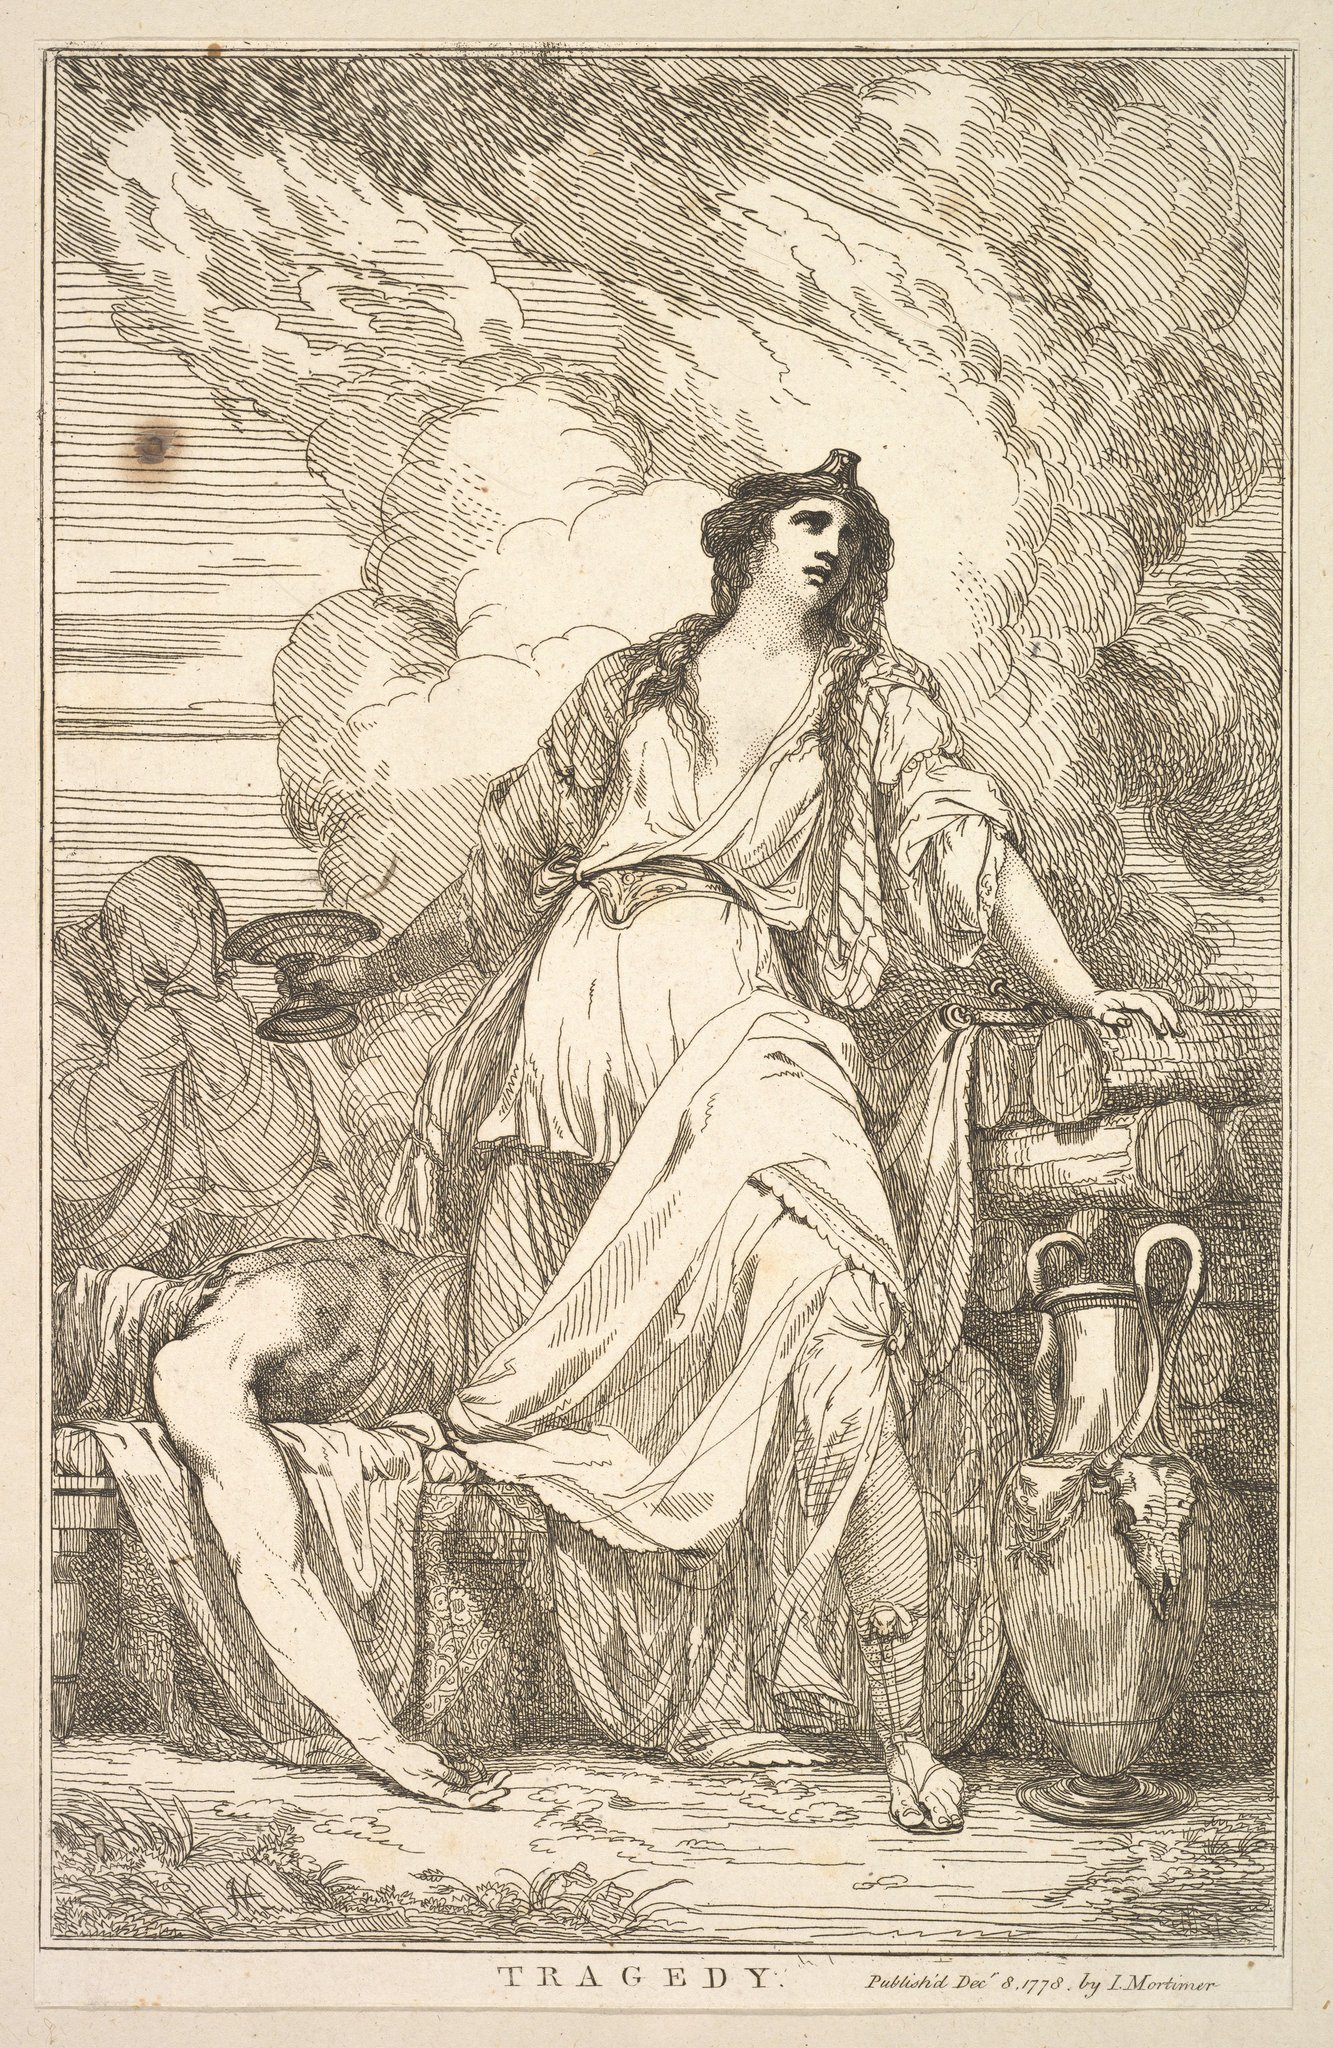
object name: print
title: Tragedy, from "Fifteen Etchings Dedicated to Sir Joshua Reynolds"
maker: john hamilton mortimer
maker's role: artist and publisher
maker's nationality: british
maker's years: 1740-1779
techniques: etching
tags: women